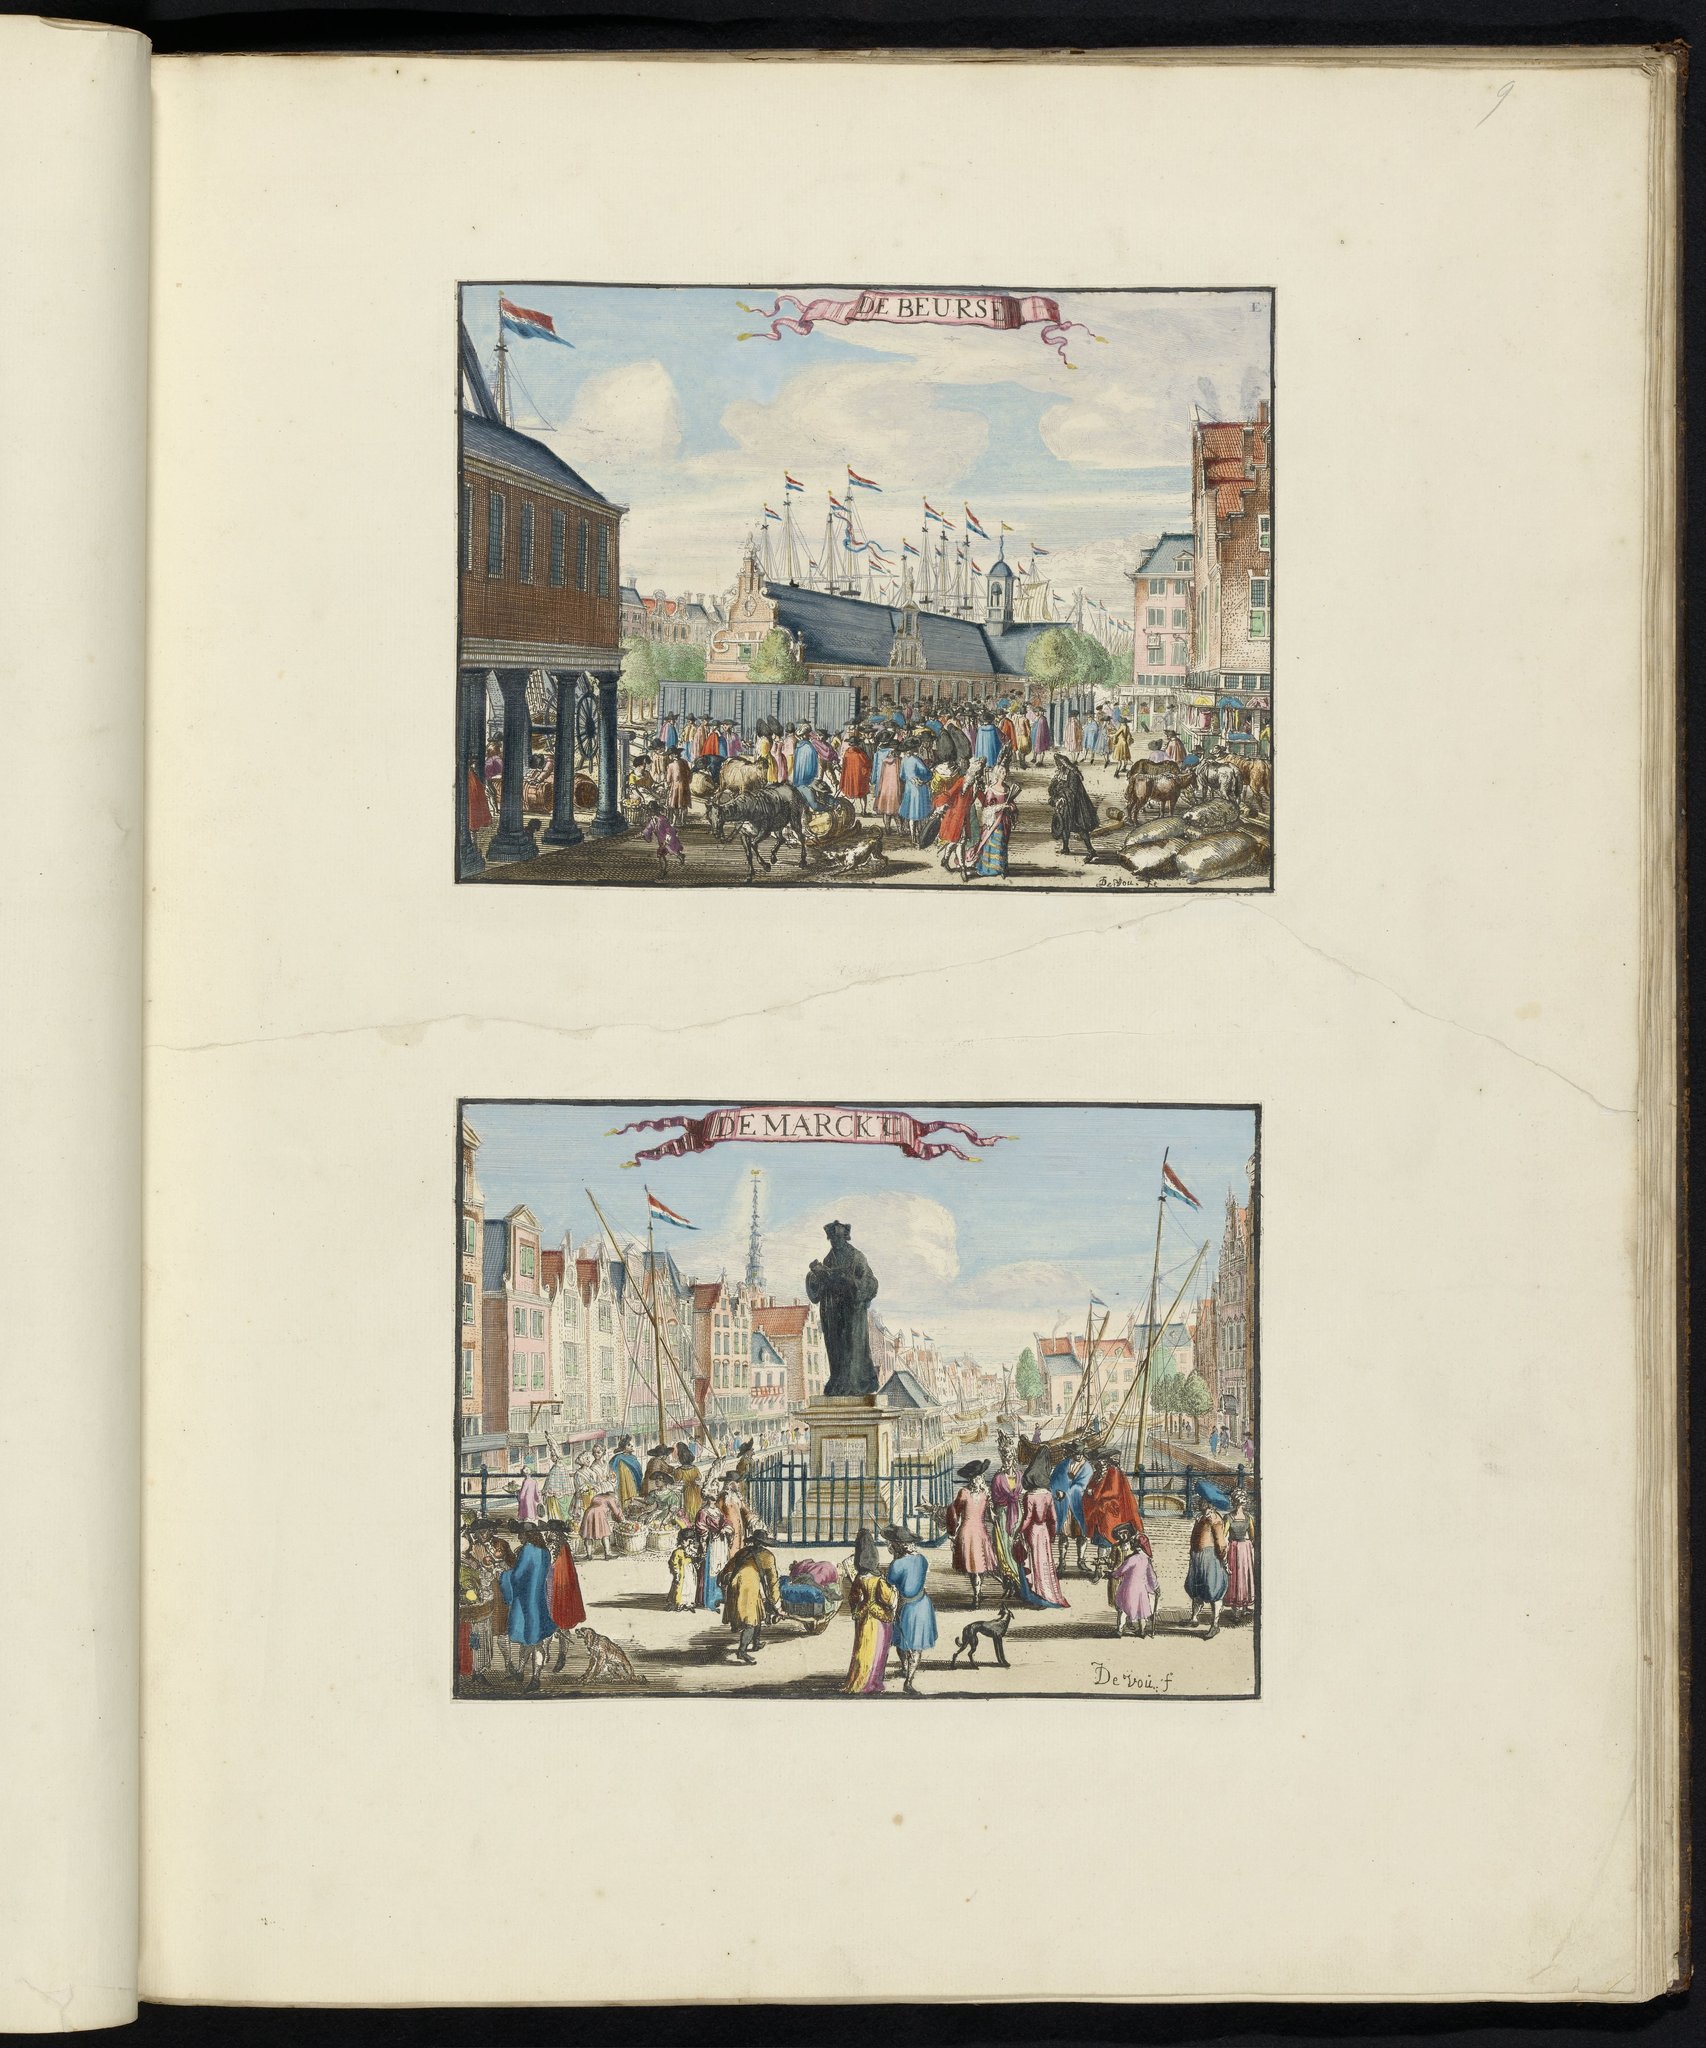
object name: print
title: Oude Beurs / Grote Markt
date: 1694-1695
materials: paper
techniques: colour, etching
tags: rotterdam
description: Twee voorstellingen op een albumblad. Boven een gezicht op de Grotemarkt te Rotterdam met het standbeeld van Desiderius Erasmus. Onder de beurs in de voormalige vismarkt aan de Blaak te Rotterdam, gezien vanuit het oosten. Dit gebouw deed van 1635 tot 1736 dienst als beurs. Rechtsboven de letters E en F. De prenten zijn onderdeel van de kaart van Rotterdam door Johannes de Vouw en maken deel uit van een album.